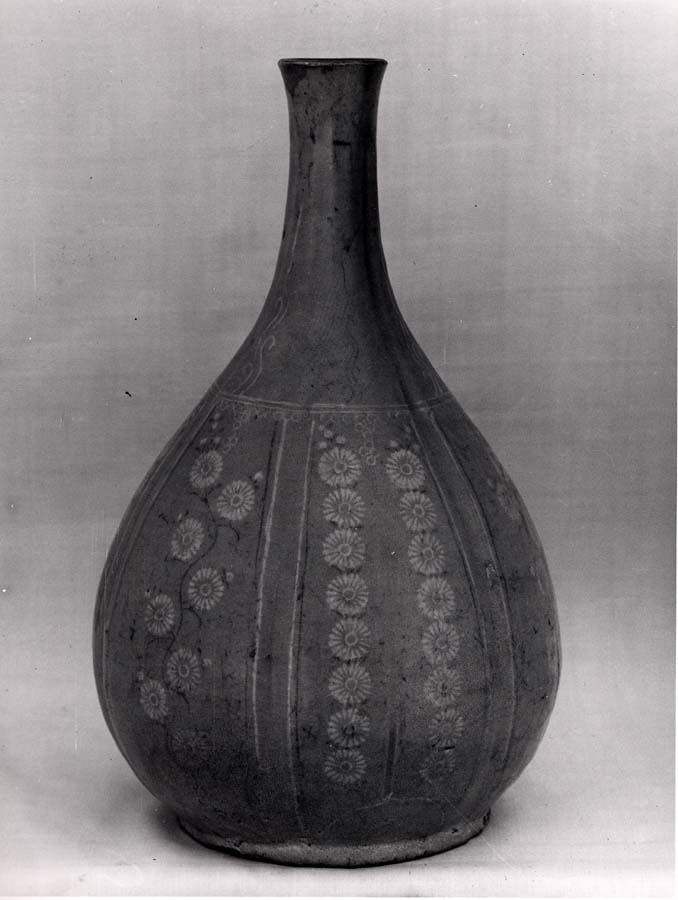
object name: vase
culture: korean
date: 1901-1933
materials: pottery